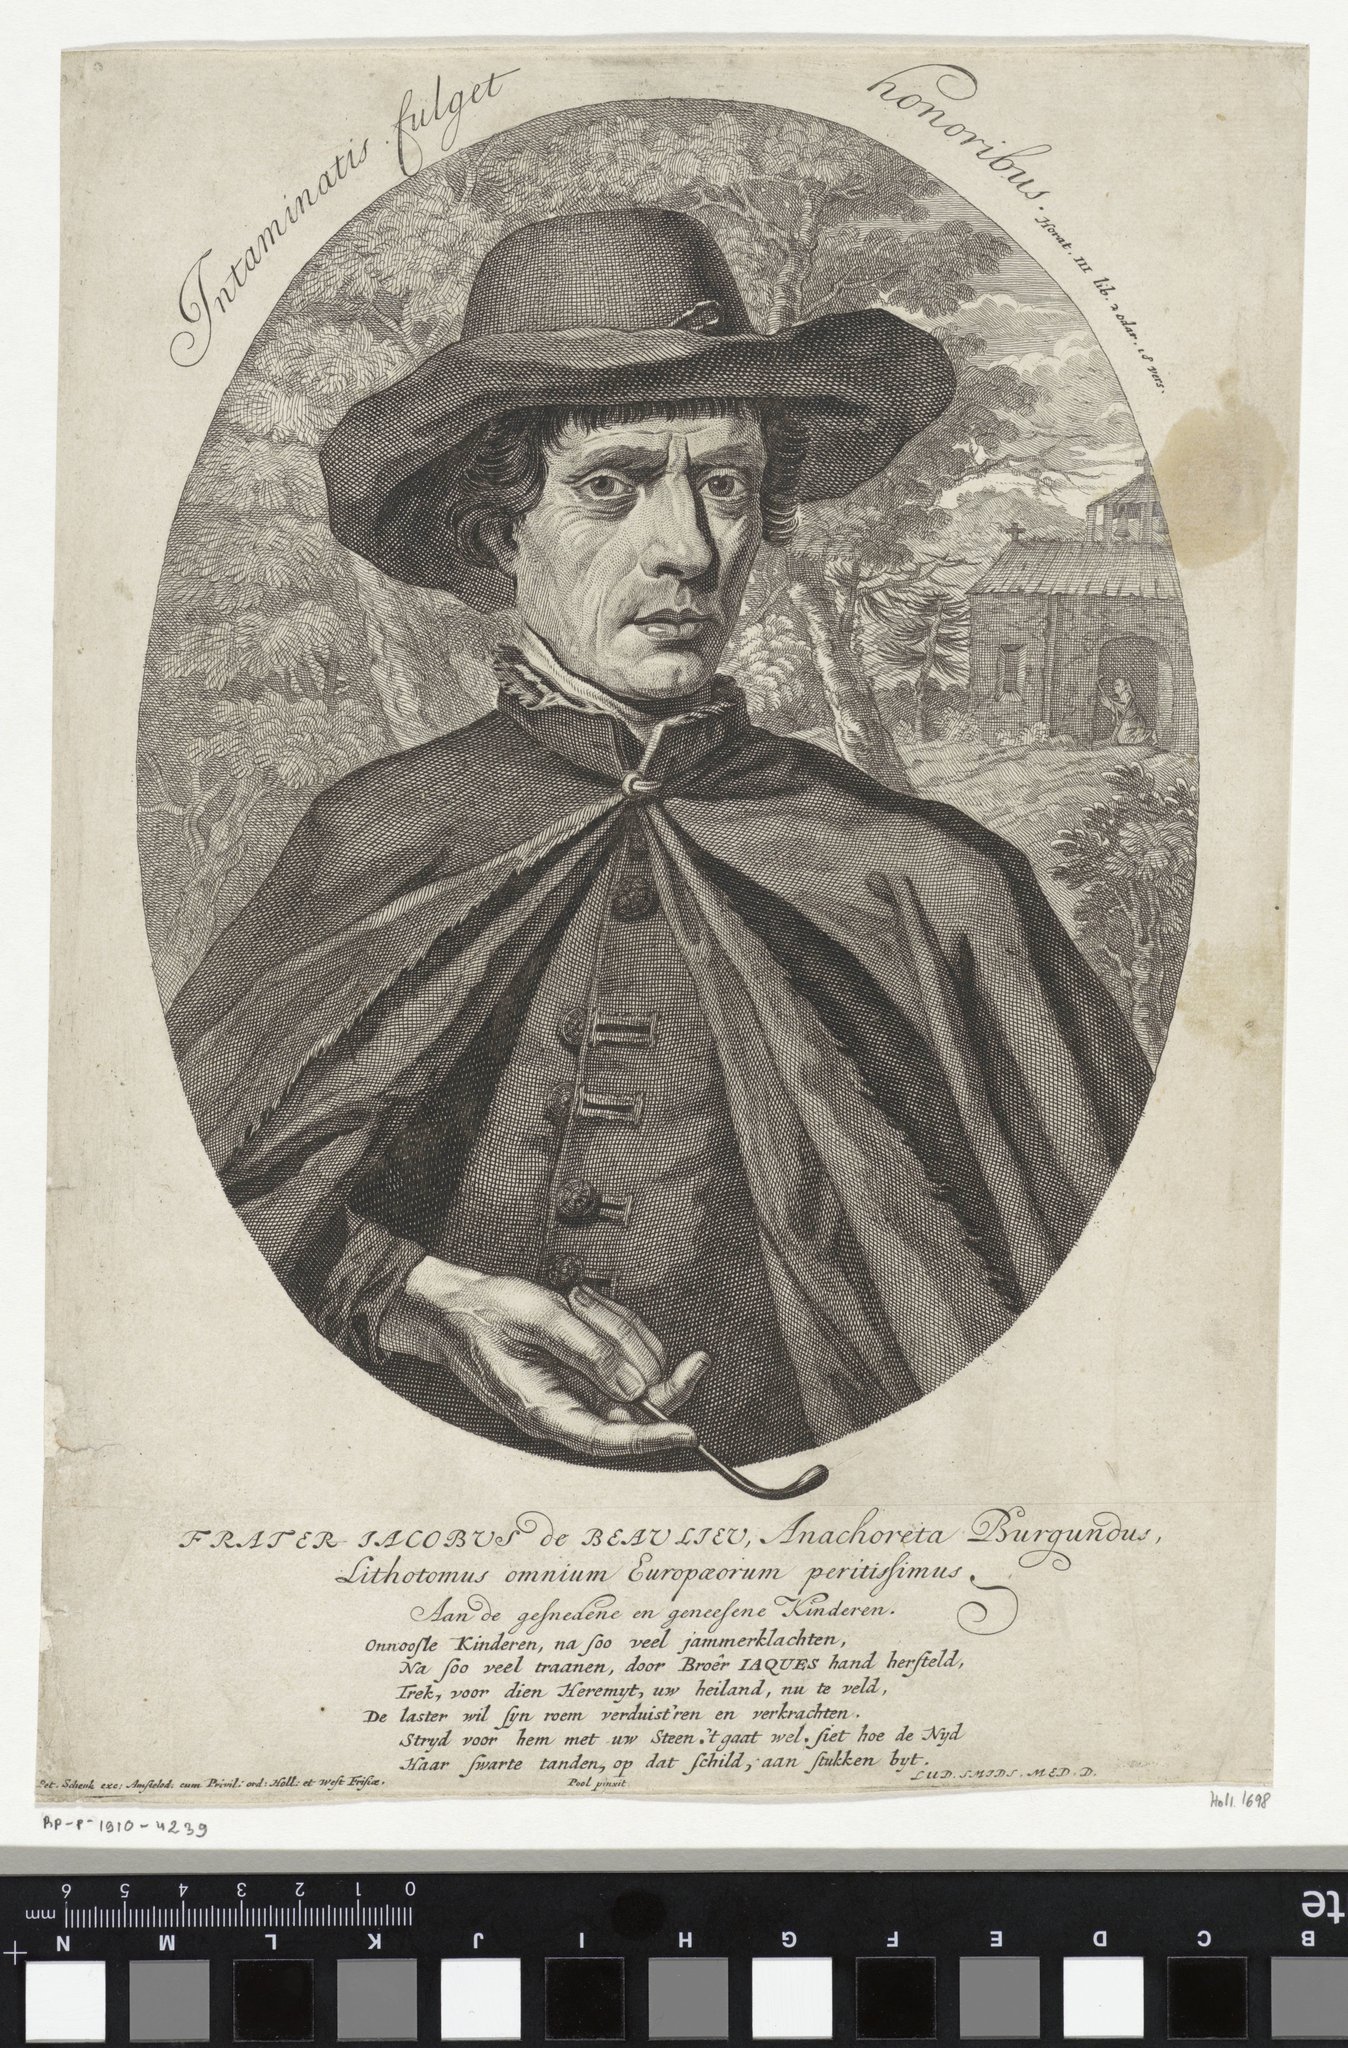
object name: print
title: Portret van frère Jaques de Beaulieu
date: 1675-1711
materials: paper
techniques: engraving, etching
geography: amsterdam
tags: france, head-gear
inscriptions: collector's mark: Lugt 2228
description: Borstbeeld van frère Jaques de Beaulieu die tijdens twee bezoeken aan Amsterdam een aantal blaassteenoperaties verrichte. In zijn hand houdt hij een instrument dat hij voor zijn operaties gebruikte.